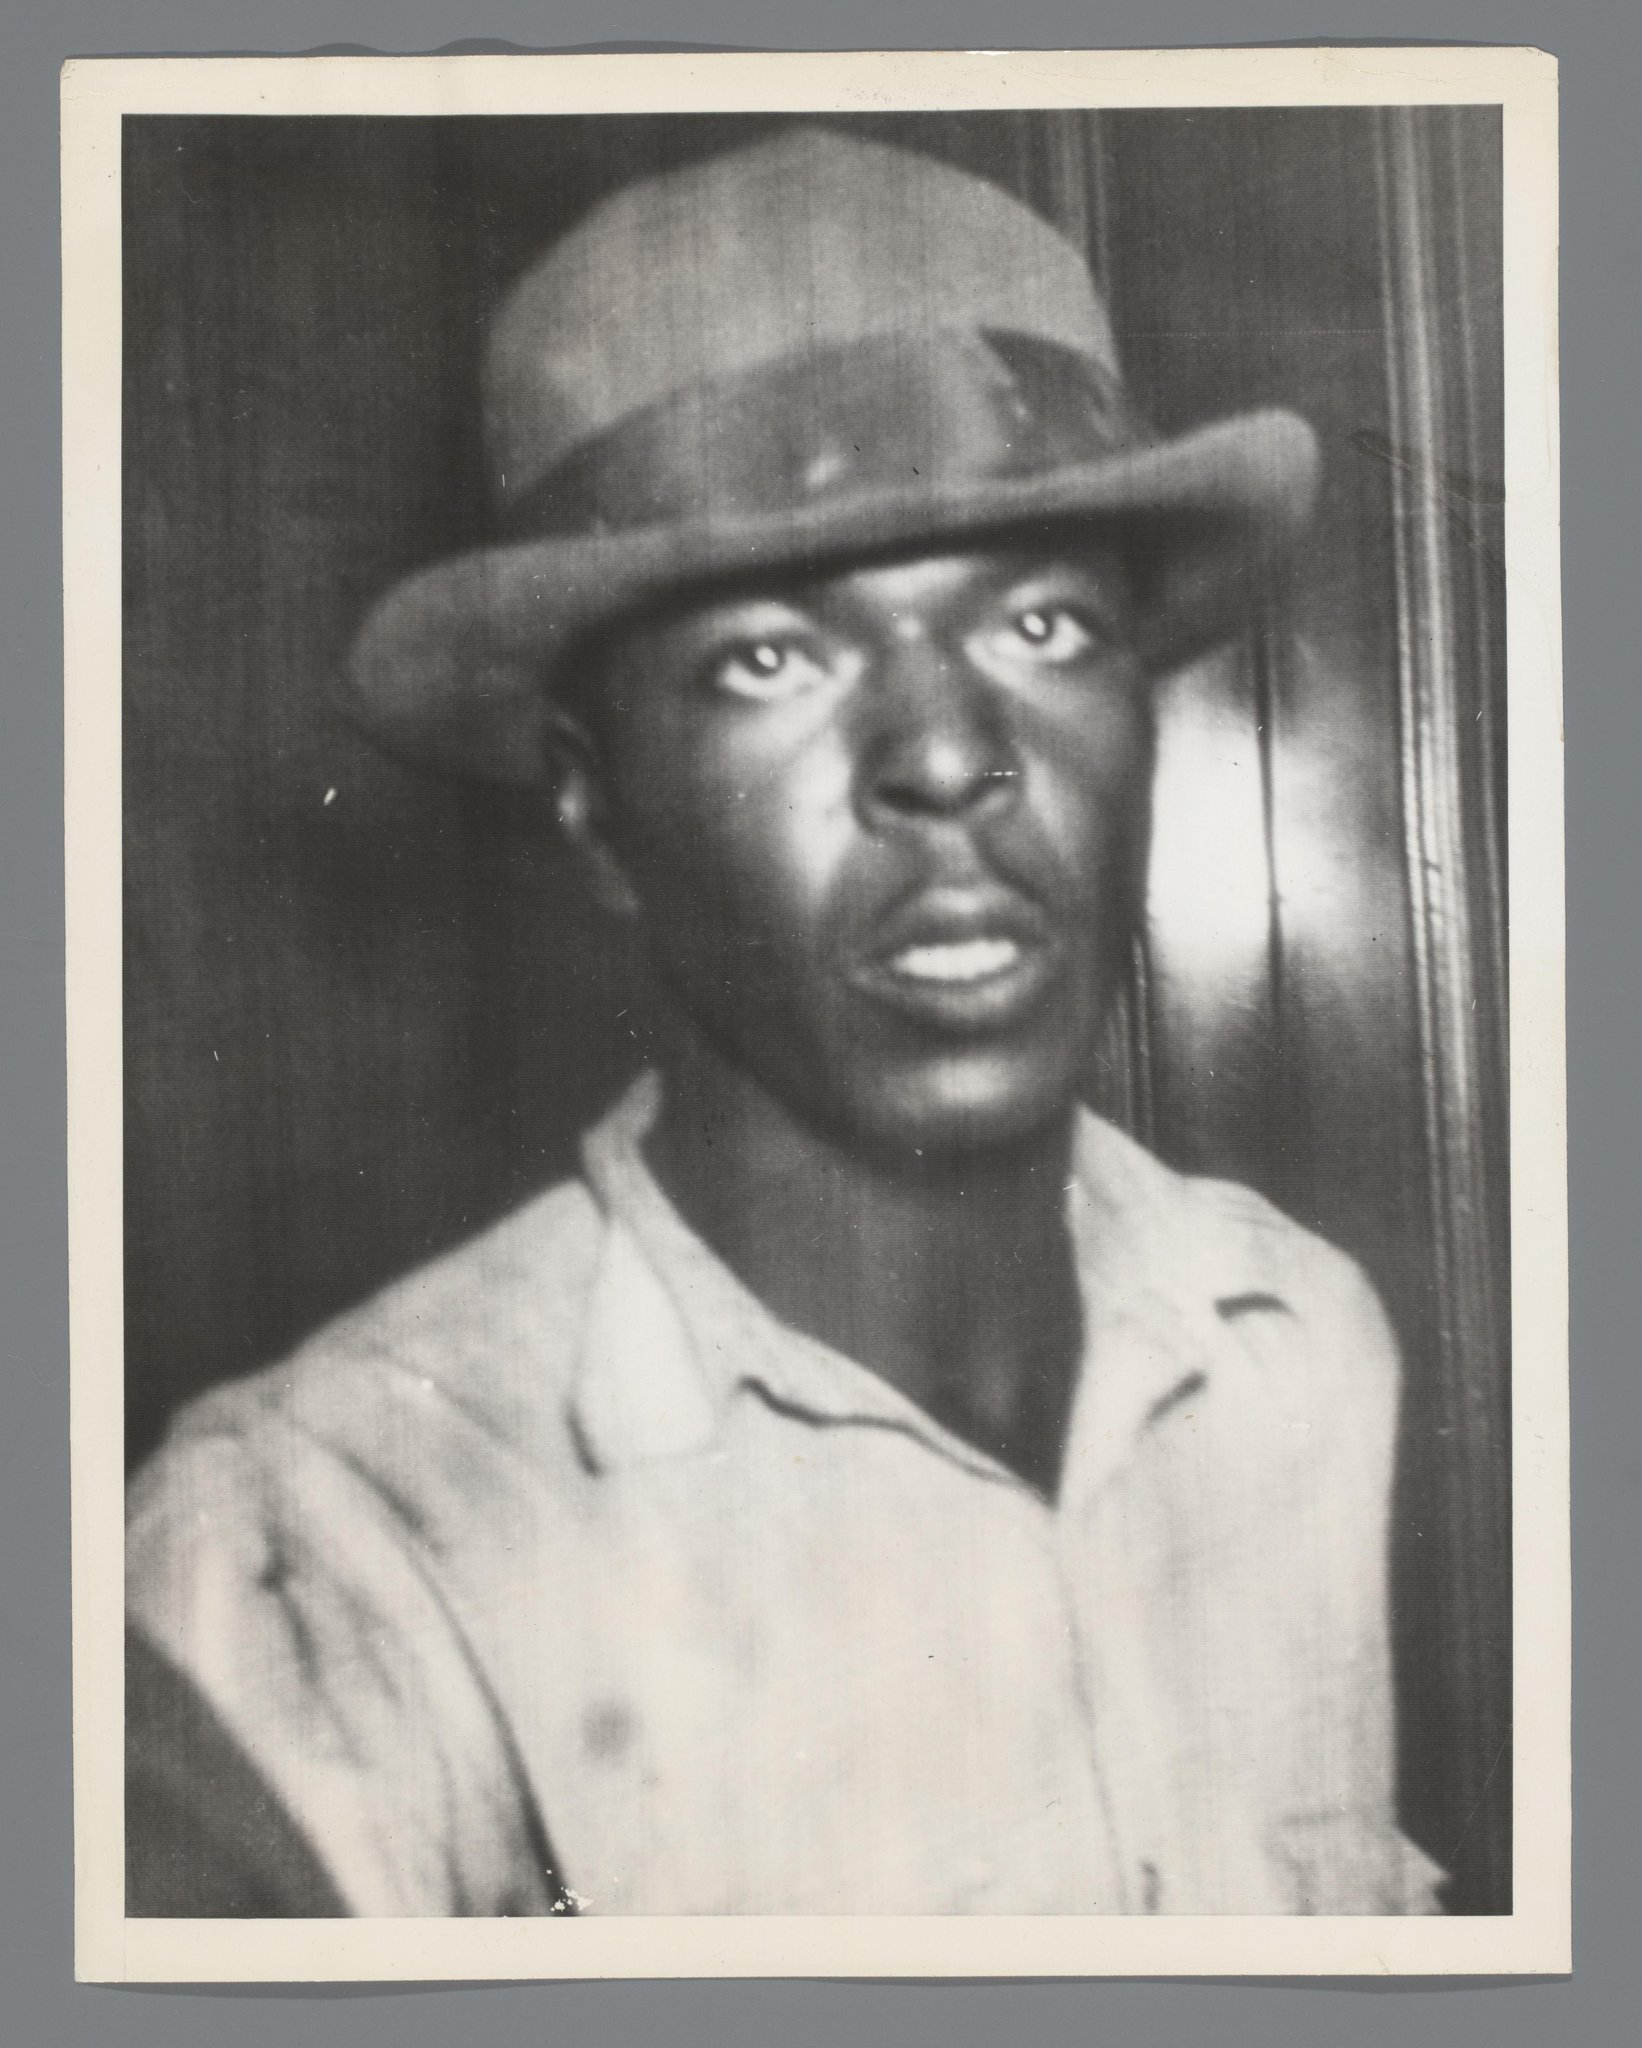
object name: photograph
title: Portret van John Manuel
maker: Anonymous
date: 1938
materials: paper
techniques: gelatin silver print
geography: united states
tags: adult man, historical persons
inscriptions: inscription: ‘MUST CREDIT I.N.P. SOUND PHOTO’, inscription: ‘CENTRAL PRESS/ ASSOCIATION/ JUN 6 1938/ REFERENCE DEPT.’, number: ‘1860’, inscription: ‘SOUNDPHOTO...SOUNDPHOTO .....WATCH YOUR CREDIT..INTERNATIONAL NEWSPHOTO SLUG (MANUEL) PRINCTON, FLA........PLALYER OF A STELLAR ROLE IN THE INVESTIGATION OF THE KIDNAPPING OF JAMES B. CASH, JR., IS JOHN MANUEL (ABOVE), THE NEGRO TO WHOM THE KIDNAPPERS SHOUTED INSTRUCTIONS WHEN THEY DROPPED A NOTE DEMANDING RANSOM AT HIS SHACK. YESTERDAY MANUEL WAS AT THE FEDERAL BUREAU OF INVESTIGATION HEADQUARTERS HIDDEN BEHIND A SCREEN WHILE G-MEN QUESTIONED A SCORE OF MEN. HIS PART WAS TO DETECT, IF POSSIBLE, THE VOICE WITH THE ''FOREIGN ACCENT'' THAT SHOUTED TO HIM LAST SATURDAY NIGHT WHEN 5-YEAR-OLD JIMMY CASH WAS SNATCHED FROM HIS HOUSE. w.6-3-38-2.30’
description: John Manuel was getuige van de ontvoering van James B. Cash.